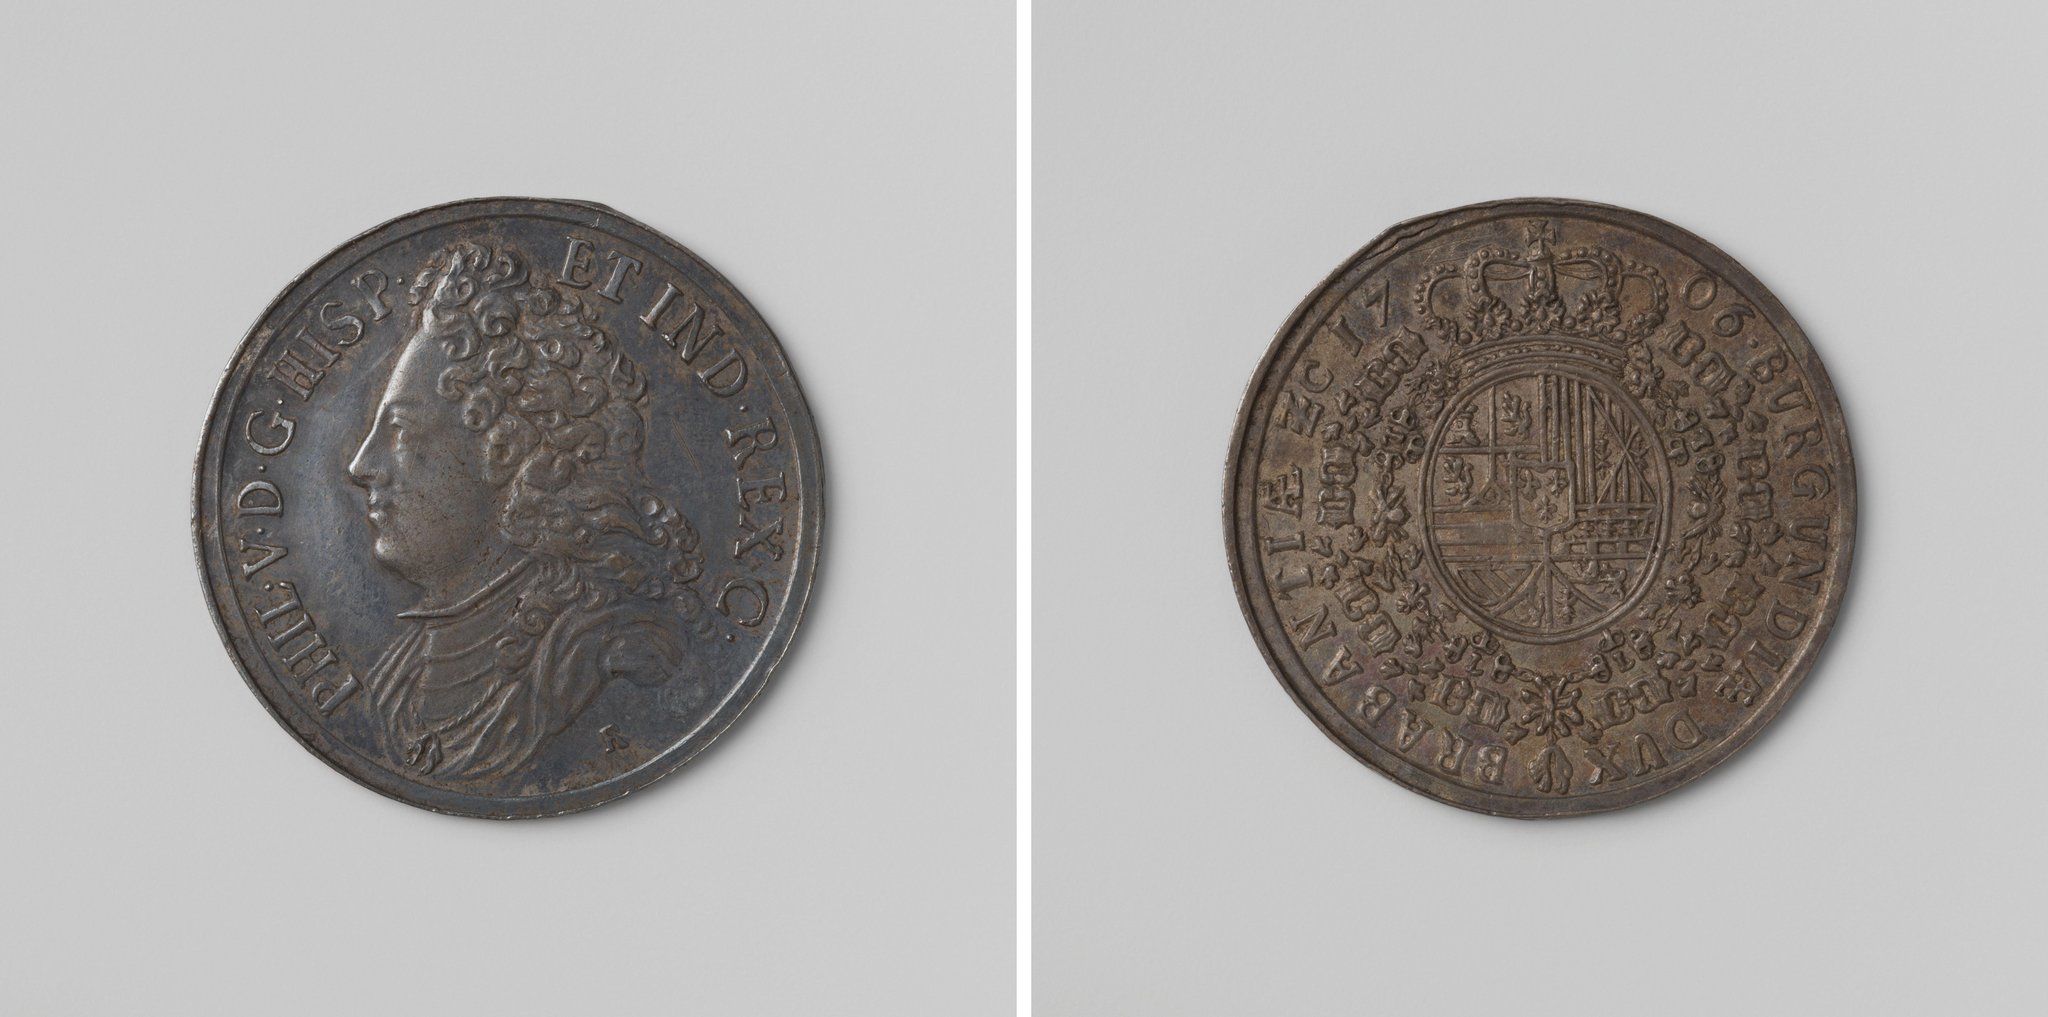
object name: new year medal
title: Filips V, koning van Spanje, hertog van Bourgondie en Brabant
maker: philippe roëttiers (ii)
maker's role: medailleur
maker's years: 1640-1718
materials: silver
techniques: striking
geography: antwerp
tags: filips v (koning van spanje)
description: Zilveren penning. Voorzijde: borststuk man binnen omschrift. Keerzijde: gekroond wapenschild, omhangen met de orde van het Gulden Vlies en de orde van de Heilige Geest binnen omschrift